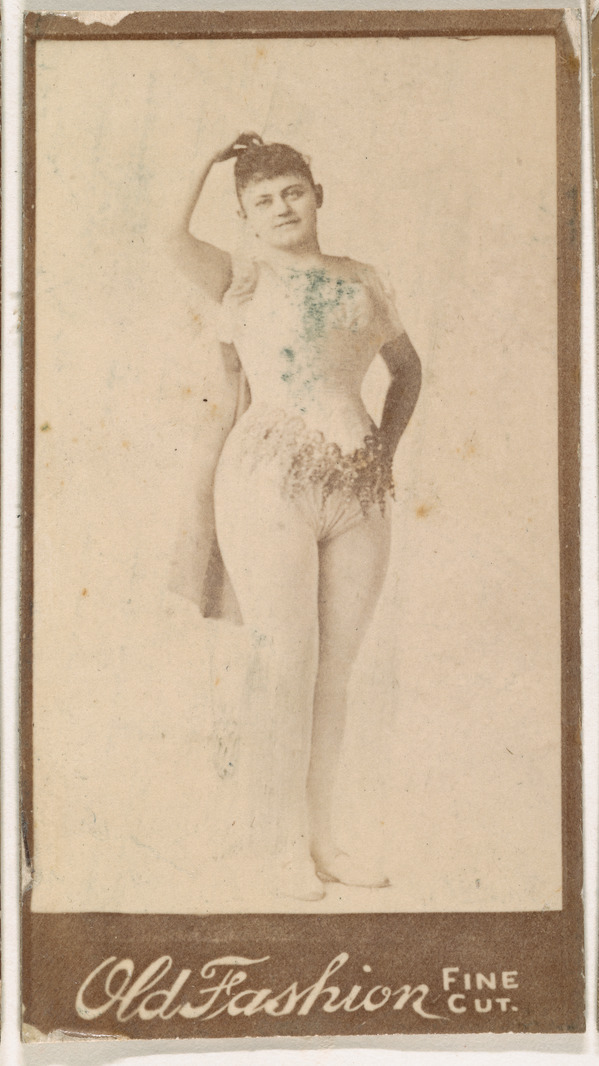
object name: photograph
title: Actress holding hand to head, from the Actresses series (N664) promoting Old Fashion Fine Cut Tobacco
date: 1888-1890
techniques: albumen silver print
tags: portraits,women,actresses